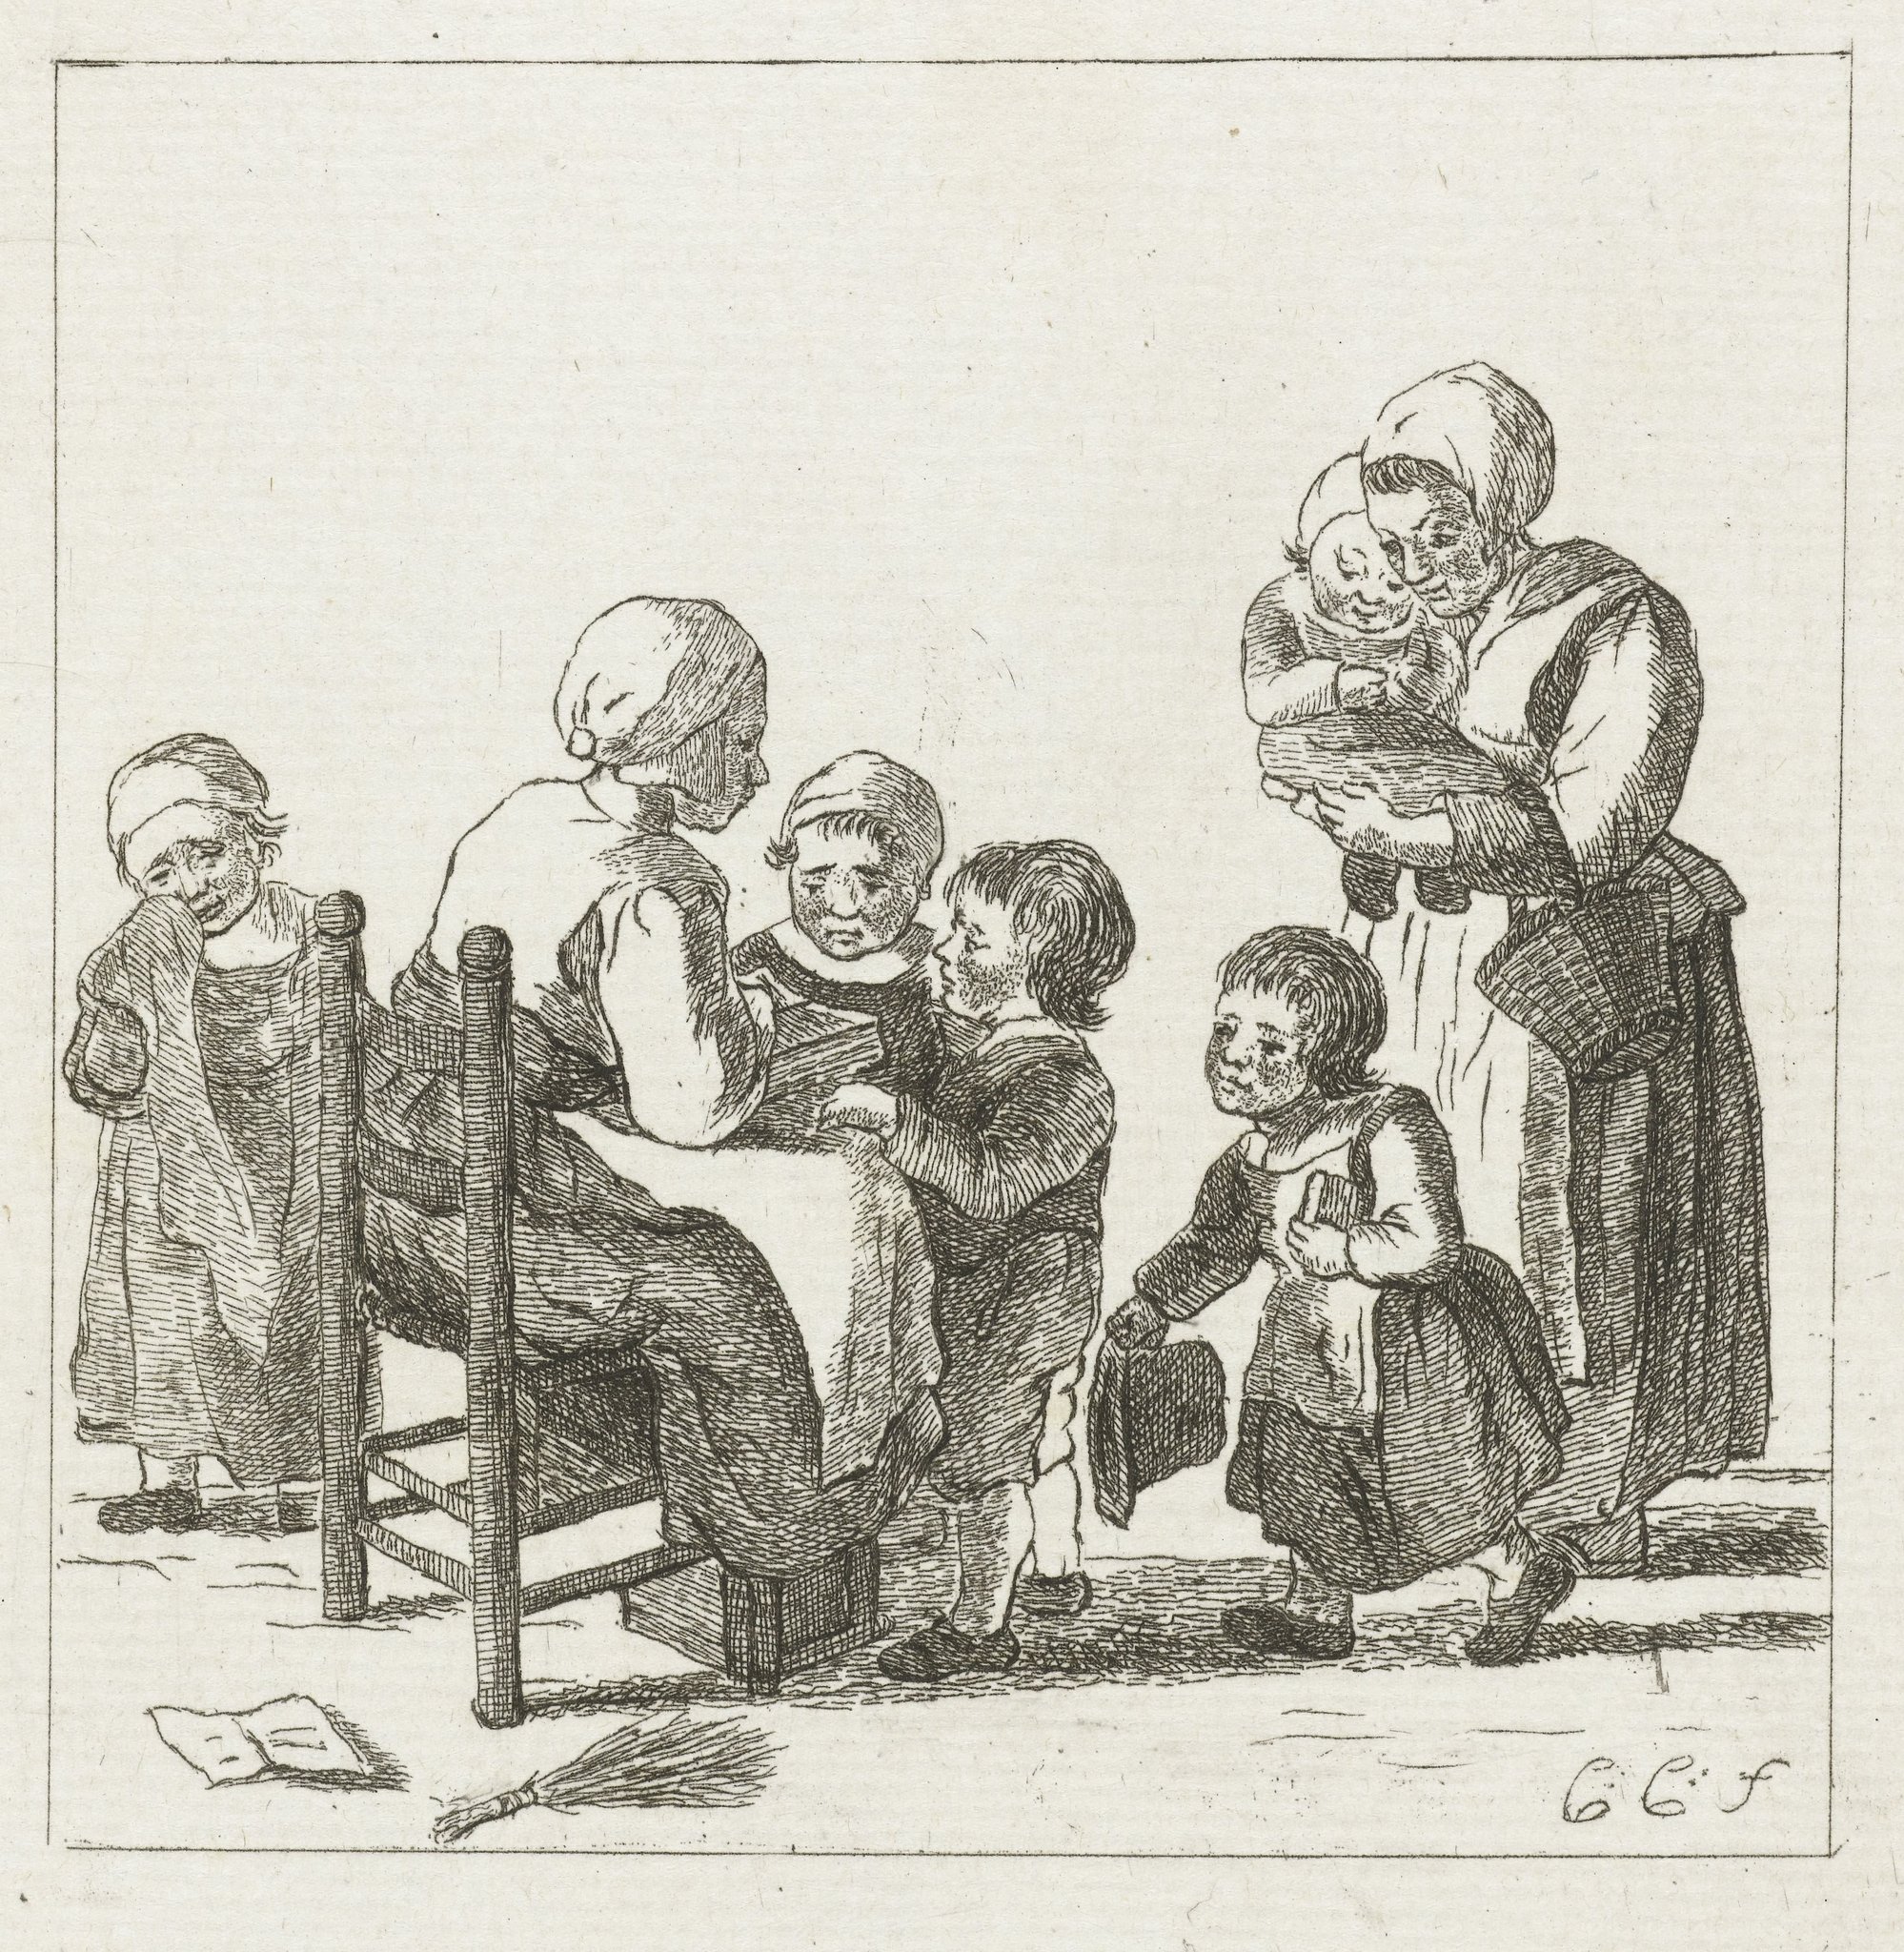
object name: print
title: Schoolklas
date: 1779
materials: paper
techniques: etching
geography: leiden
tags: teacher and pupil, rod, birch ~ punishment at school, nursery school, mischievous child (at school)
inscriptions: collector's mark: Lugt 2233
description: Een kinderschool. Een lerares zit op een stoel en leest kinderen de les uit een boek. Rechts komt een moeder haar dochter brengen. Links staat een meisje te huilen. Onder de stoel van de lerares ligt een roede.